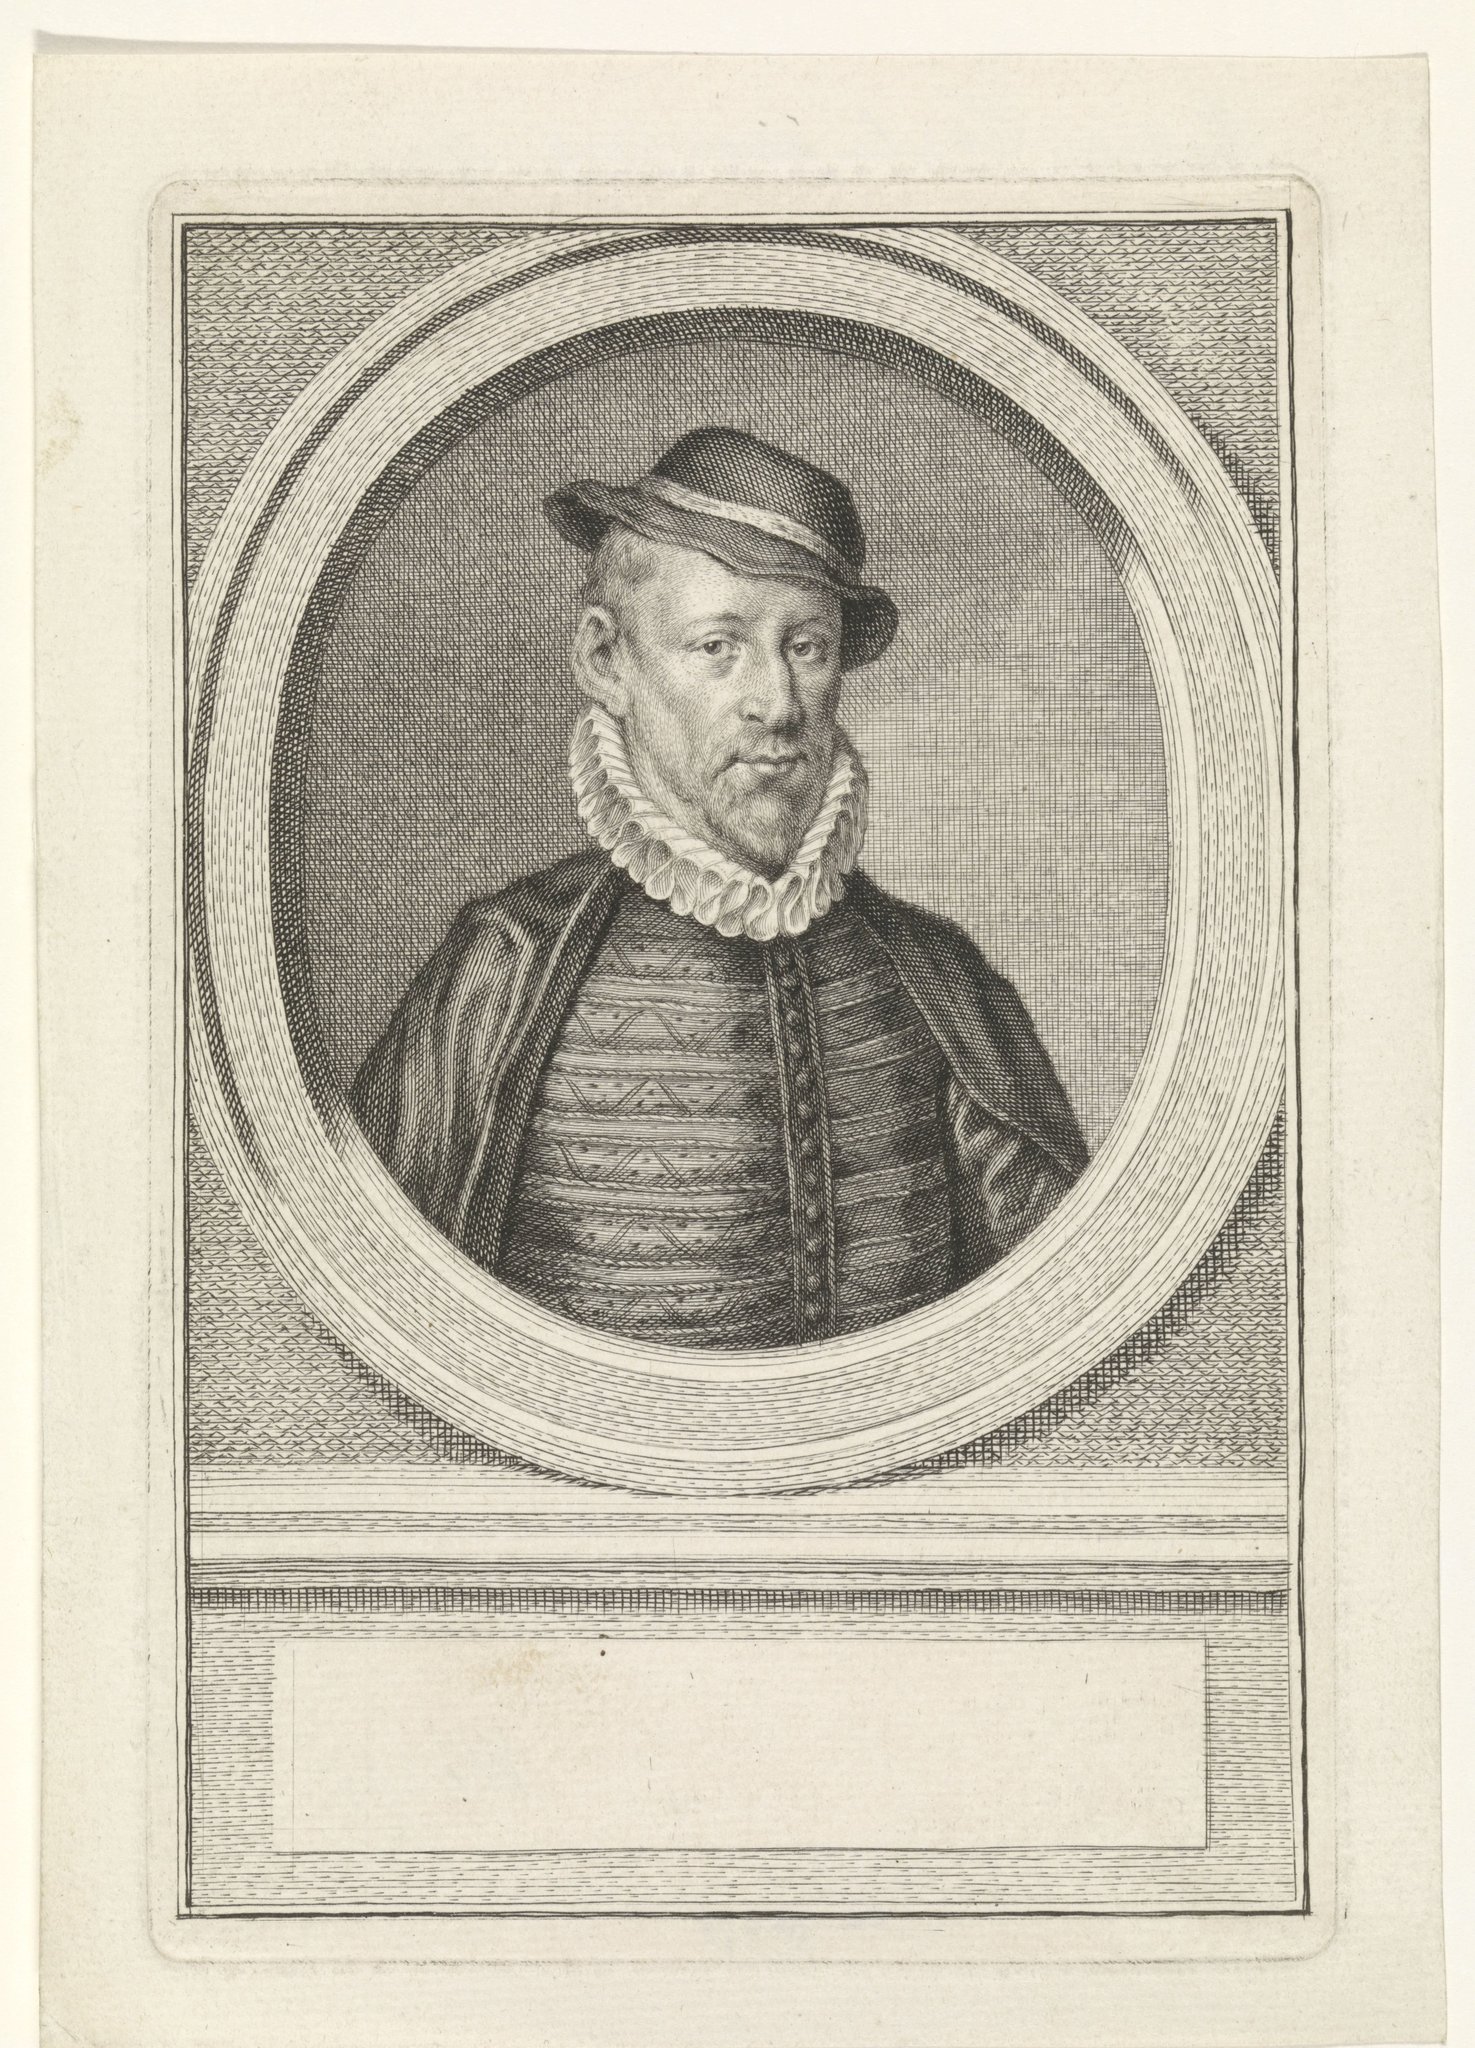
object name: print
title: Portret van Hendrick Laurensz. Spieghel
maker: jacob houbraken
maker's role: draughtsman, print maker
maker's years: 1698-1780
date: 1708-1780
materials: paper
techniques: engraving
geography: amsterdam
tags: hendrick laurensz. spieghel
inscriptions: collector's mark: Lugt 2228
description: Buste van Hendrick Laurensz. Spieghel in een ovaal. Het portret rust op een piëdestal waarop een leeg veld voor zijn naam.